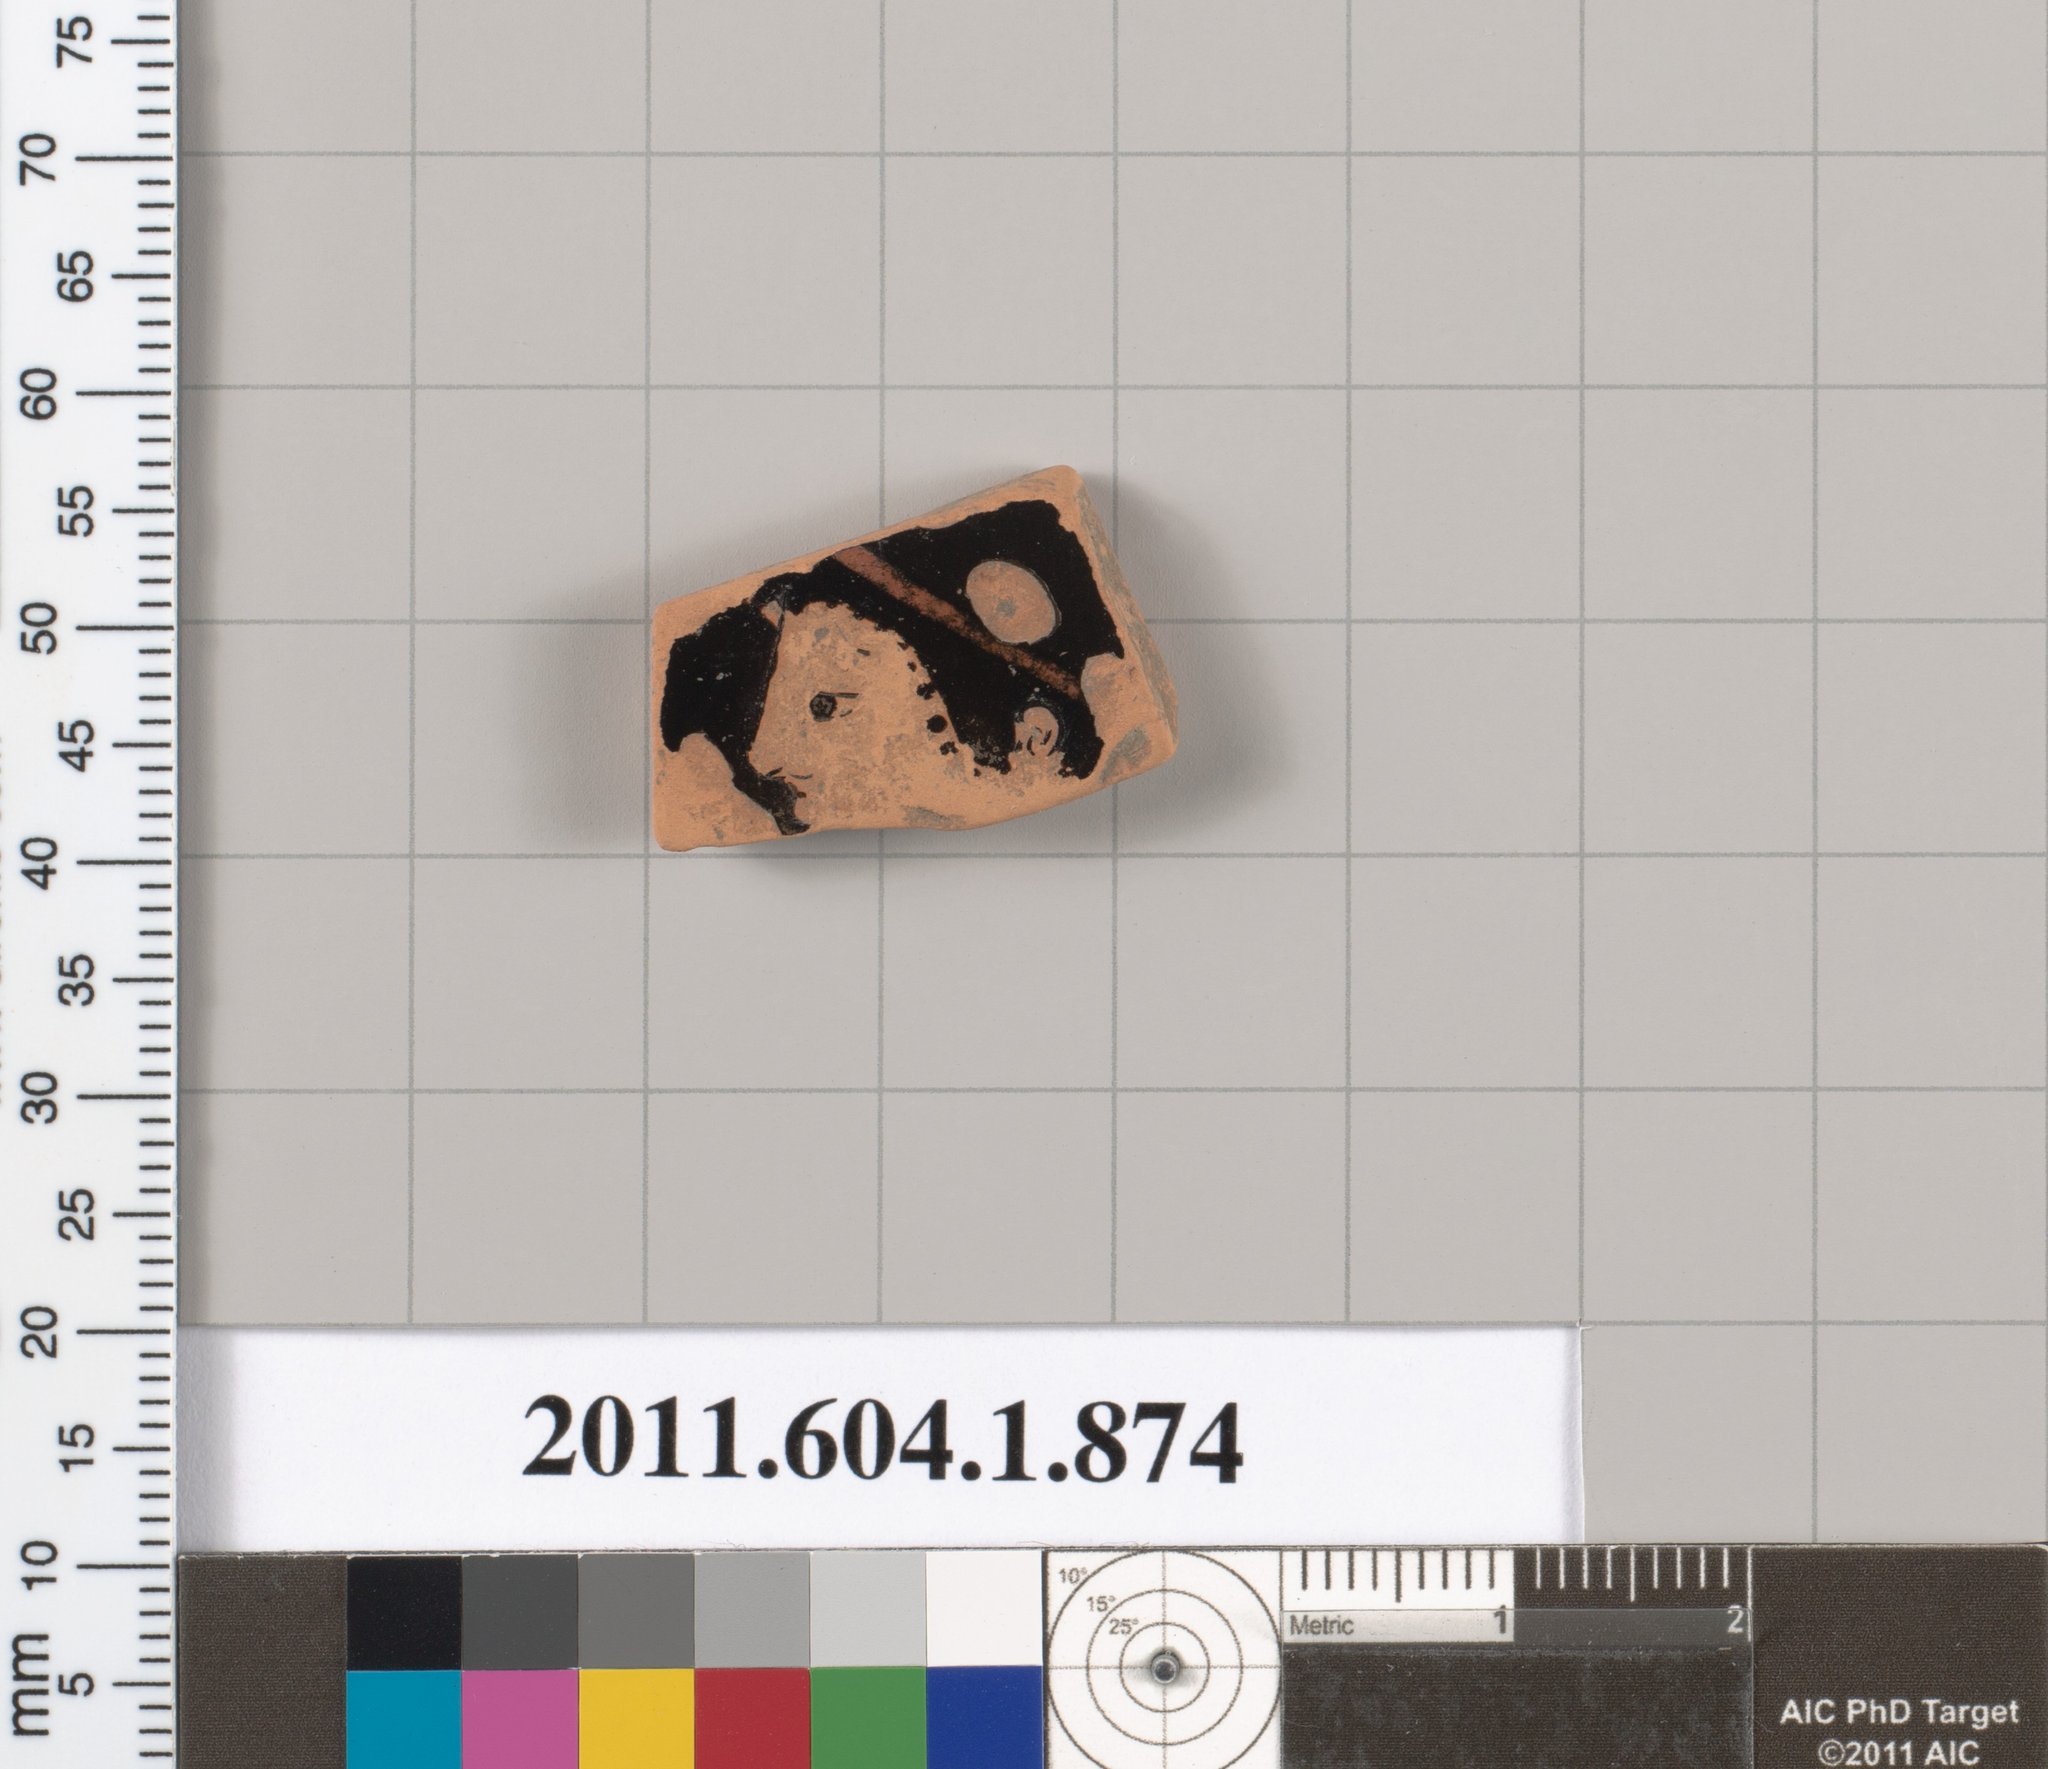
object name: kylix fragment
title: Terracotta fragment of a kylix (drinking cup)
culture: greek, attic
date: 520-500 BCE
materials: terracotta